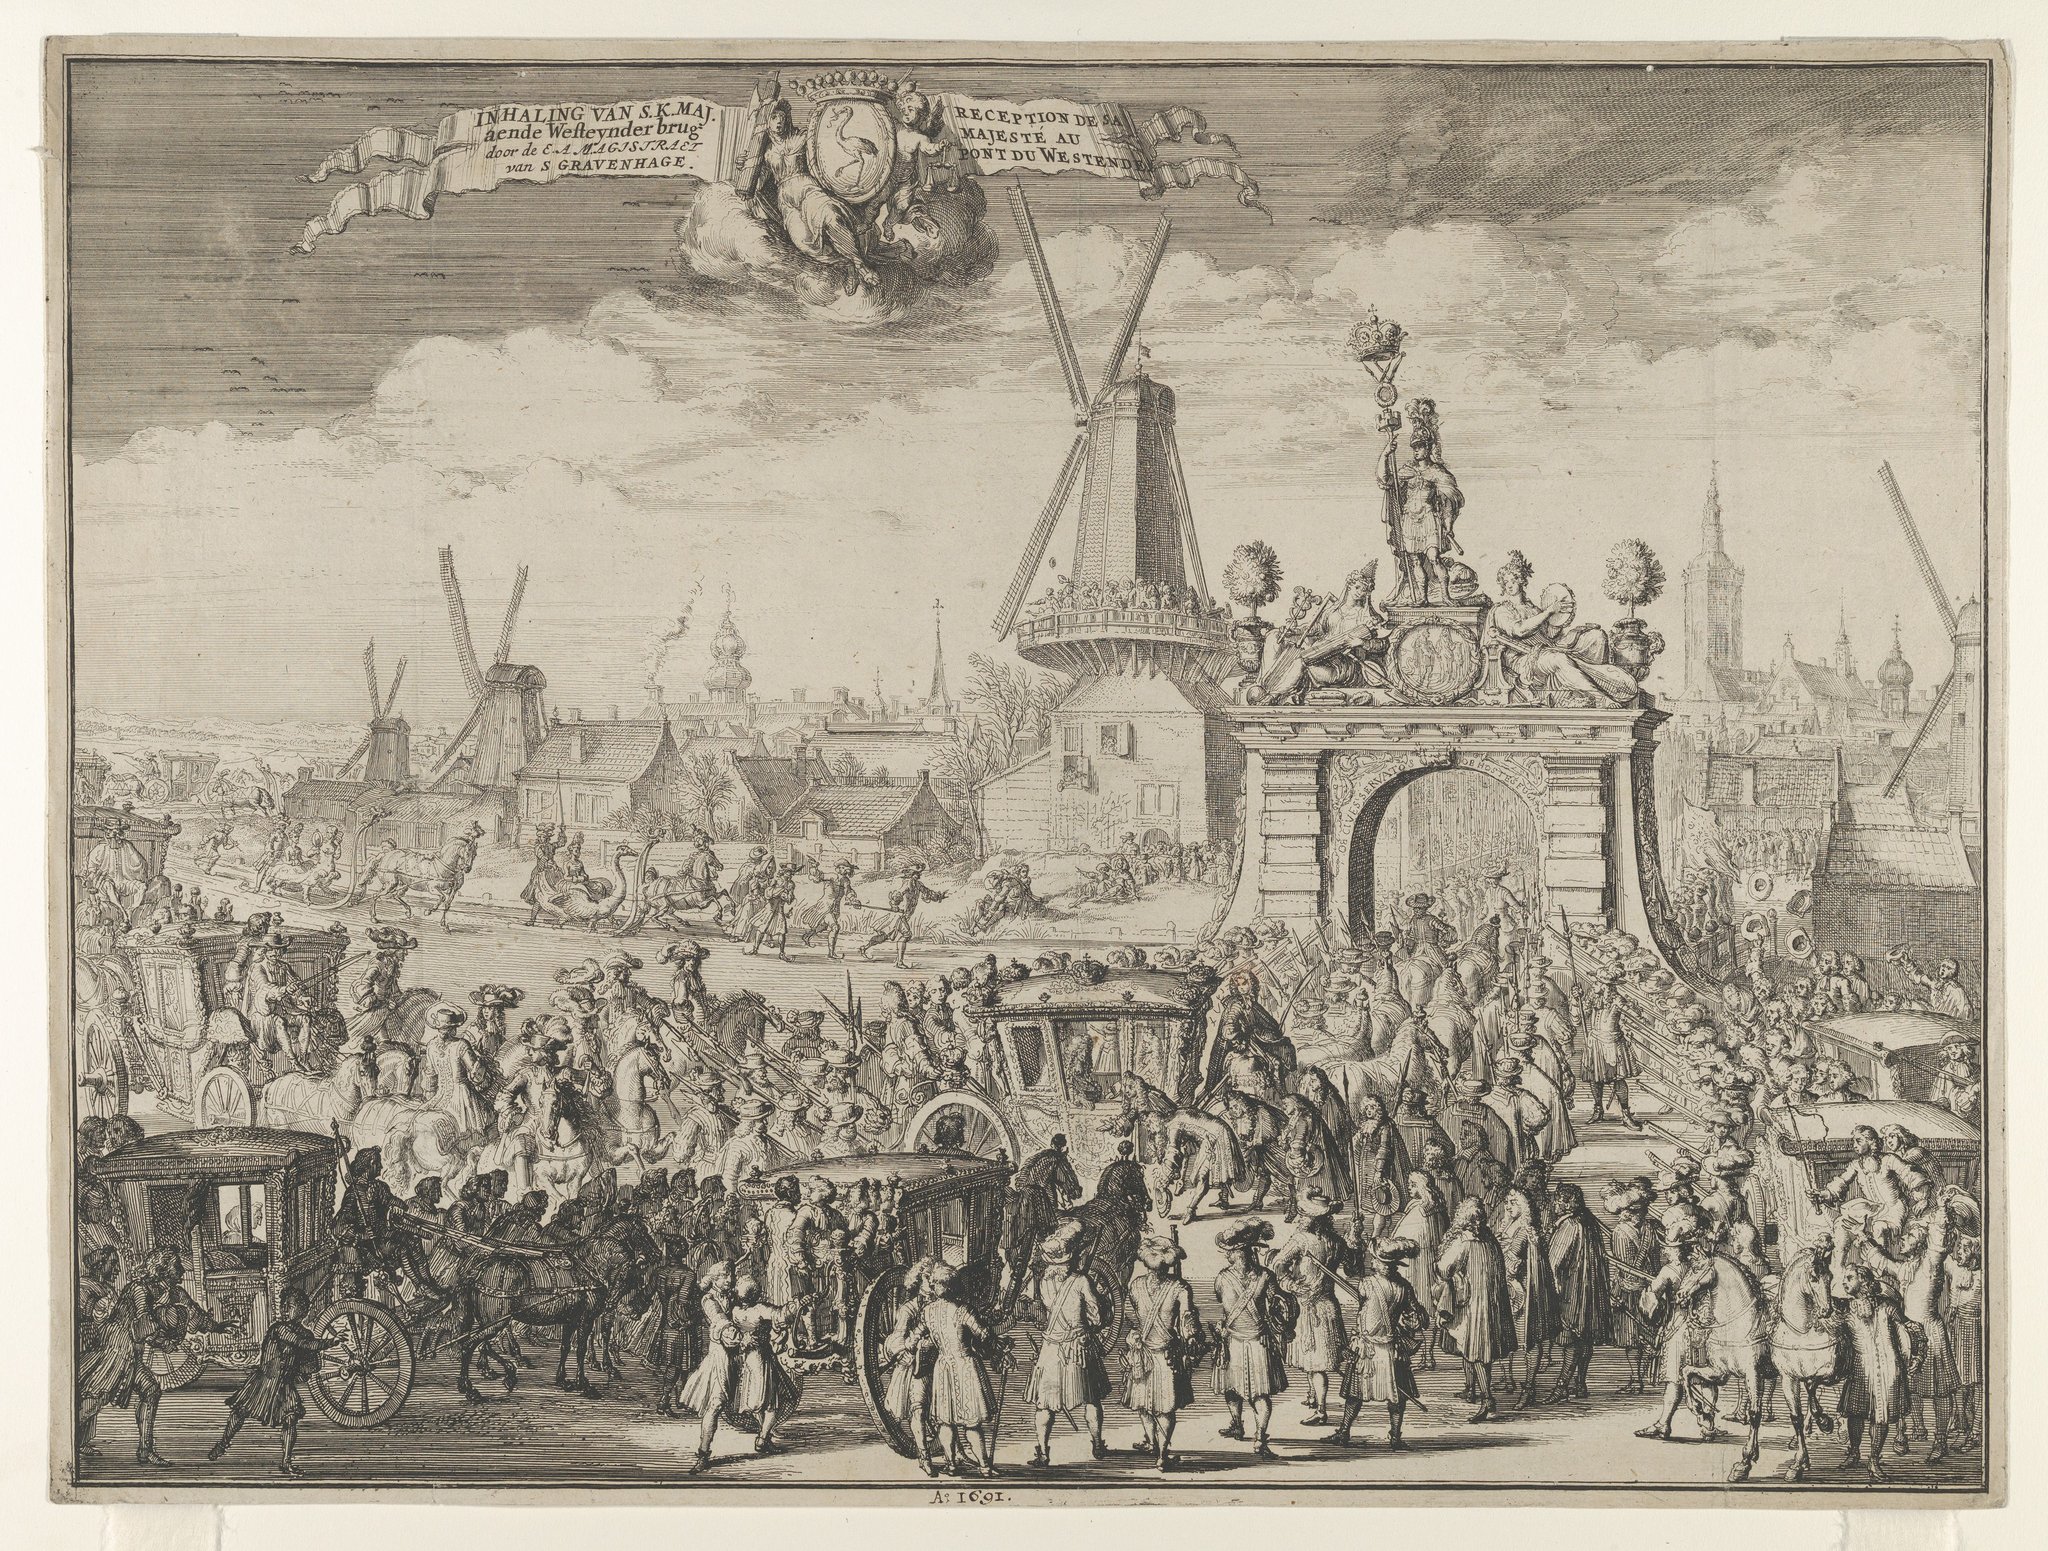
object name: print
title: Entrance of William III into The Hague (Inhaling van S.K. Maj. aende Westeynder brug door de E.A. Magistraet van s'Gravenhage / Reception de sa Majesté au pont du Westende) from Bidloo, Inkomste van Koning Willem III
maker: romeyn de hooghe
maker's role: artist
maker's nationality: dutch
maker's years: 1645-1708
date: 1691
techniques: etching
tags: gates,windmills,army,crowd,carriages